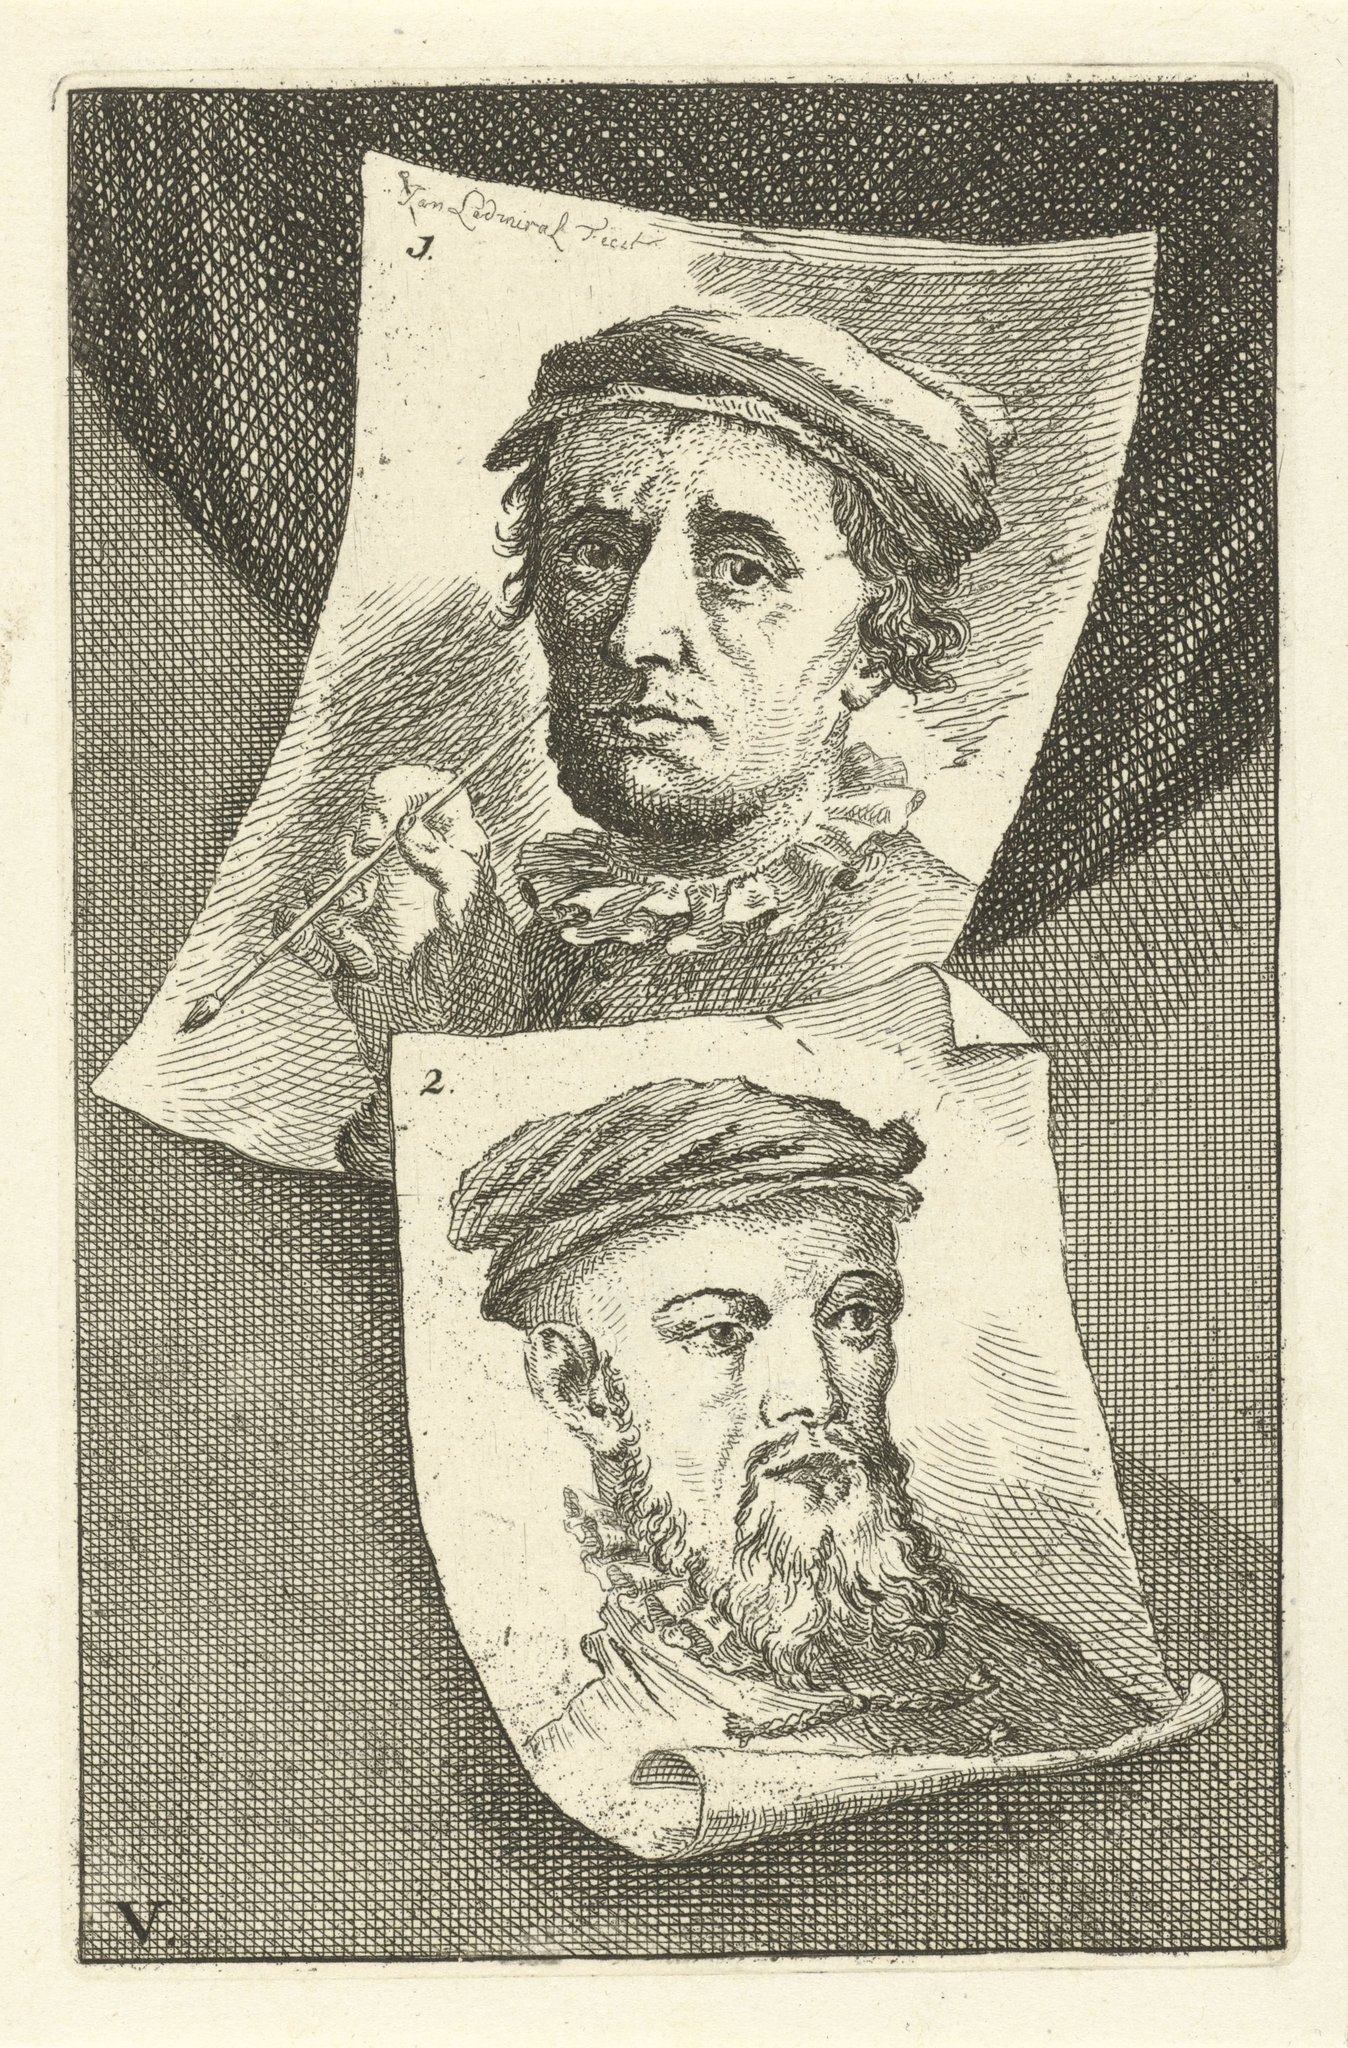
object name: print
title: Portretten van Allaert Claesz en Barend Dircksz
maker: jan l admiral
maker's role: draughtsman, print maker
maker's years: 1699-1773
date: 1764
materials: paper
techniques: etching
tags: painter, barend dircksz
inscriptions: collector's mark: Lugt 2228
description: Prent opgenomen in: Mander, Karel van; Jongh, Jacobus de (vert.). Het leven der doorluchtige Nederlandsche en eenige Hoogduitsche schilders. Amsterdam: Steven van Esveldt, 1764.